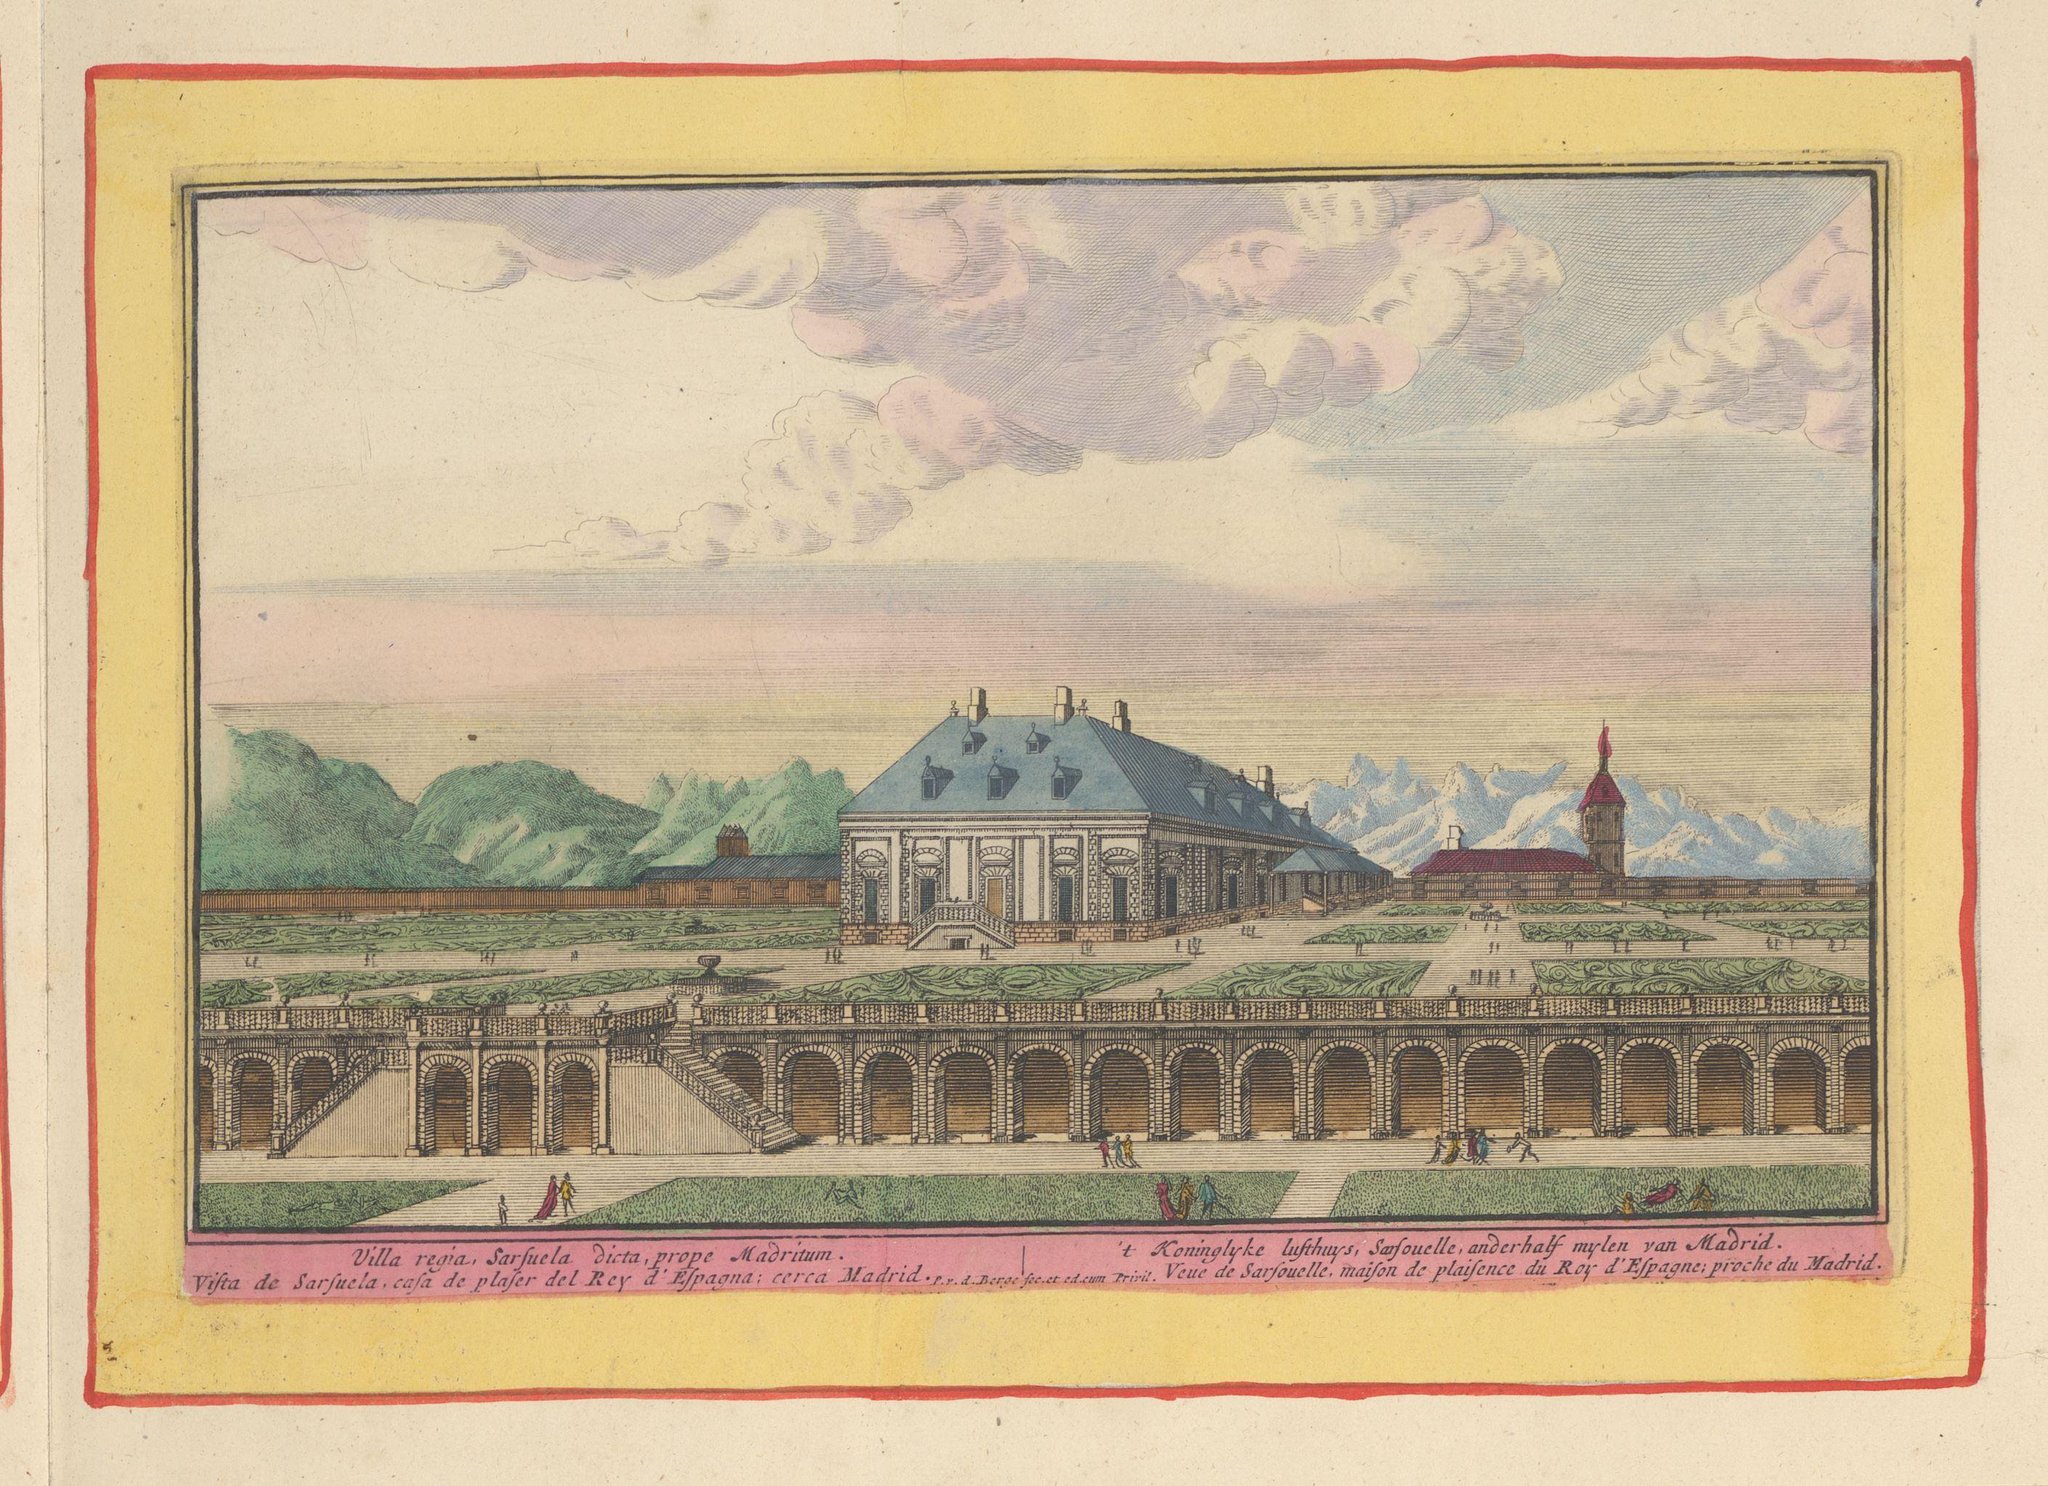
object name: book illustration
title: 't Koninglyke Lusthuys, Sarsouelle, anderhalf mylen van Madrid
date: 1694-1737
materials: paper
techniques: etching, hand coloring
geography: the hague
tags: palace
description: Prent uit: Theatrum Hispaniæ, exhibens regni urbes, villas ac viridaria magis illustria. Het aanmerkelykste en voortreffelykste in Spanjen (...). Amsterdam: Pieter van den Berge, ca. 1694-1737.